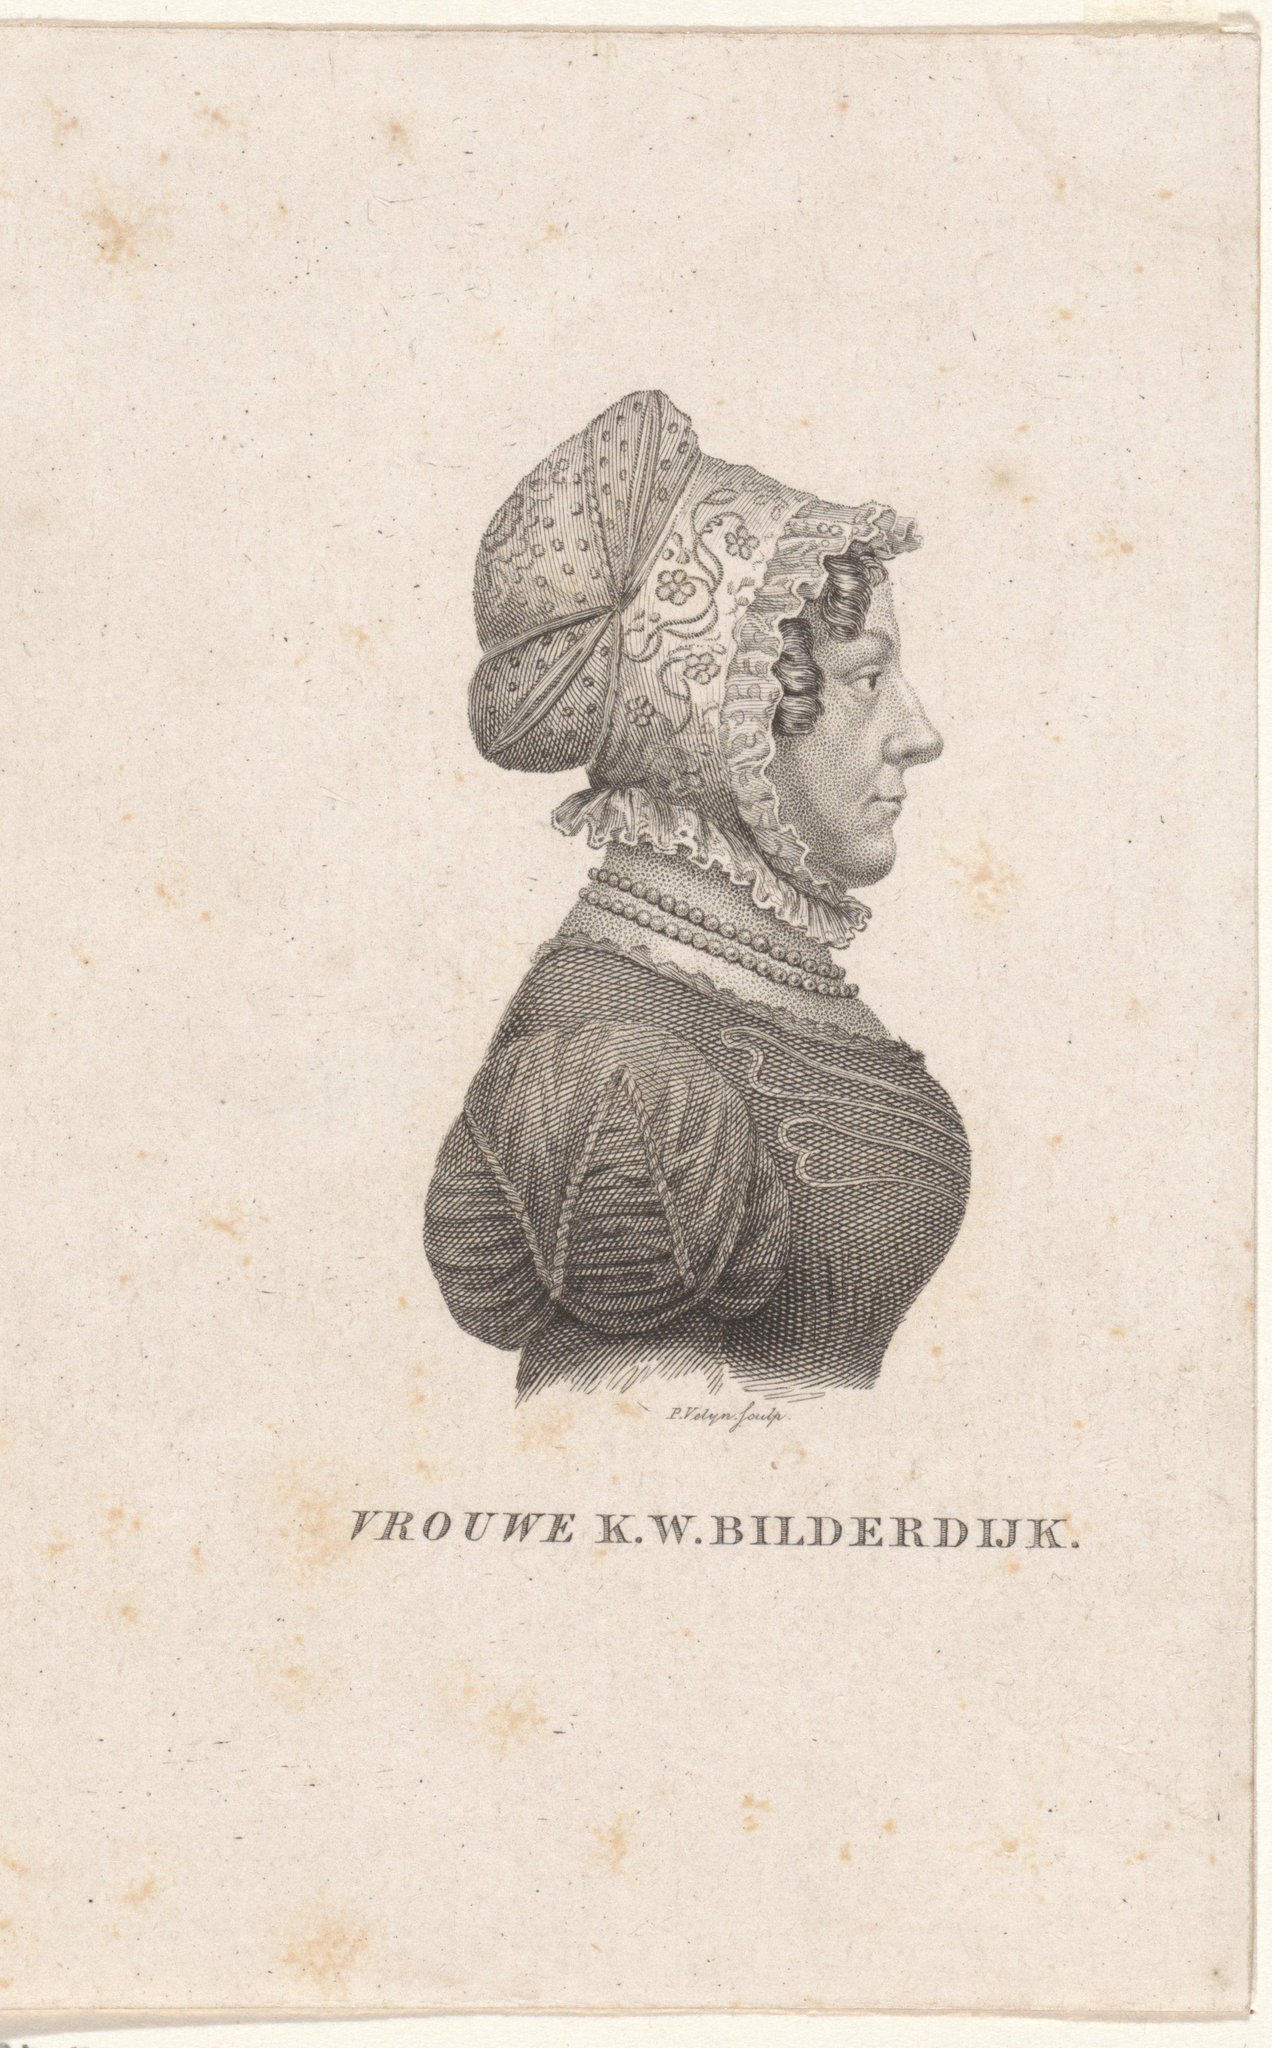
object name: print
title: Portret van Katharina Wilhelmina Schweickhardt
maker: philippus velijn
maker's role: print maker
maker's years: 1787-1836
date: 1797-1836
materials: paper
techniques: engraving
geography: netherlands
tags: the hague, haarlem, draughtsman, katharina wilhelmina schweickhardt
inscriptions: collector's mark: Lugt 2228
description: Portret van de dichteres en tekenares Katharina Wilhelmina Schweickhardt.